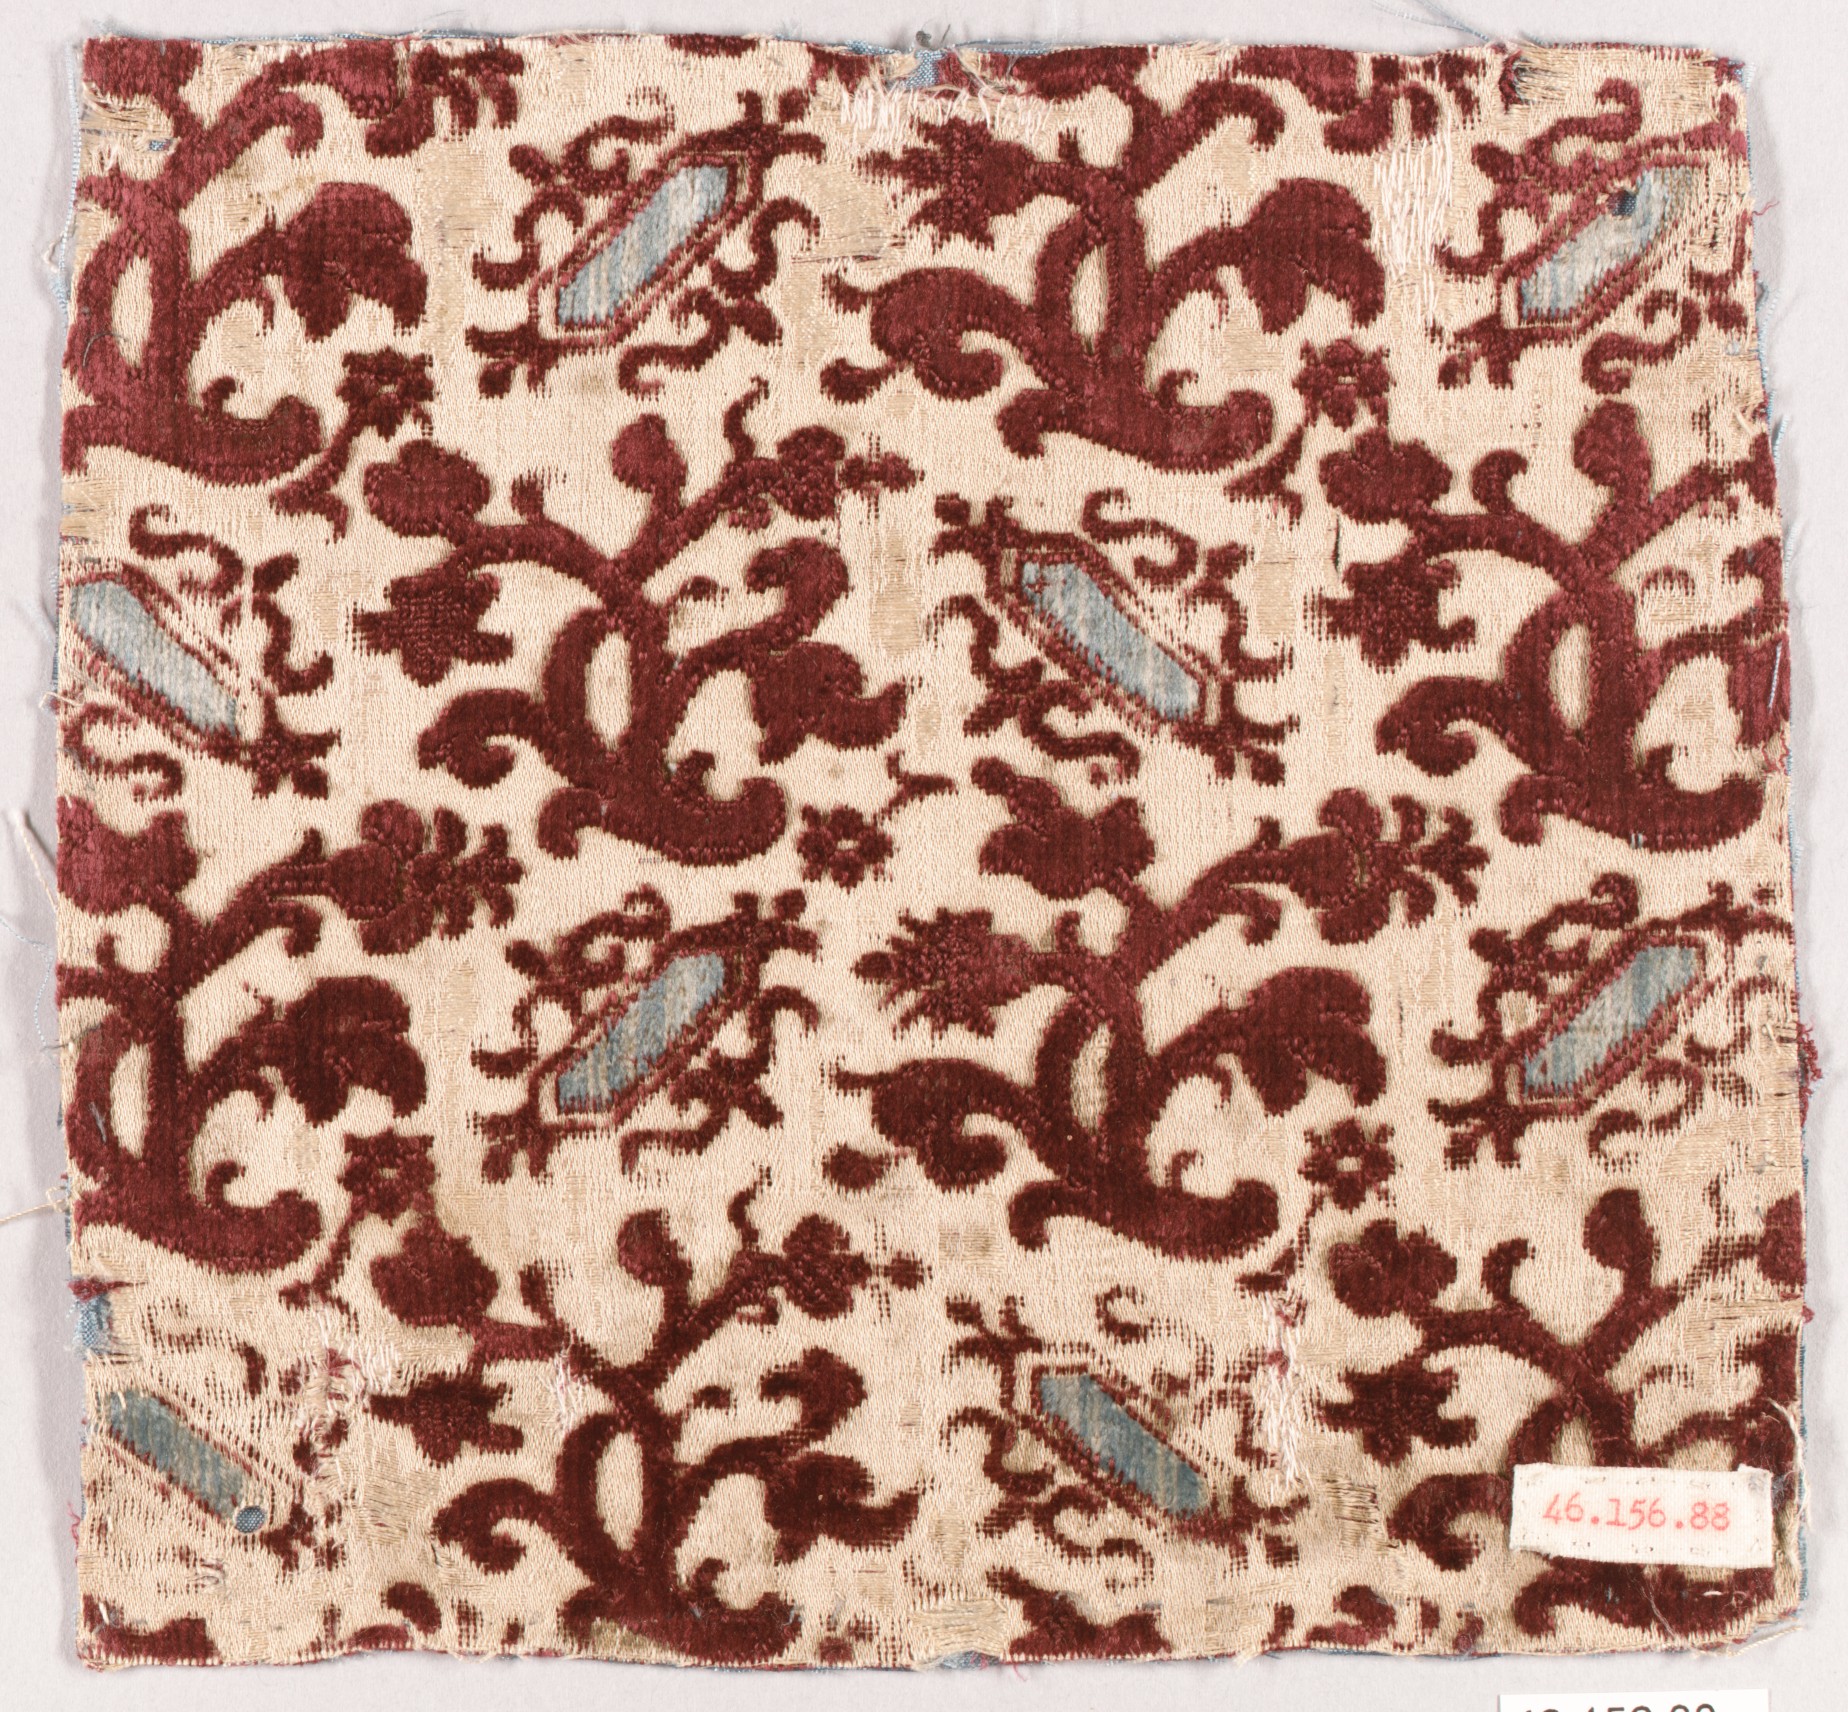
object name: piece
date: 1567-1600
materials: silk